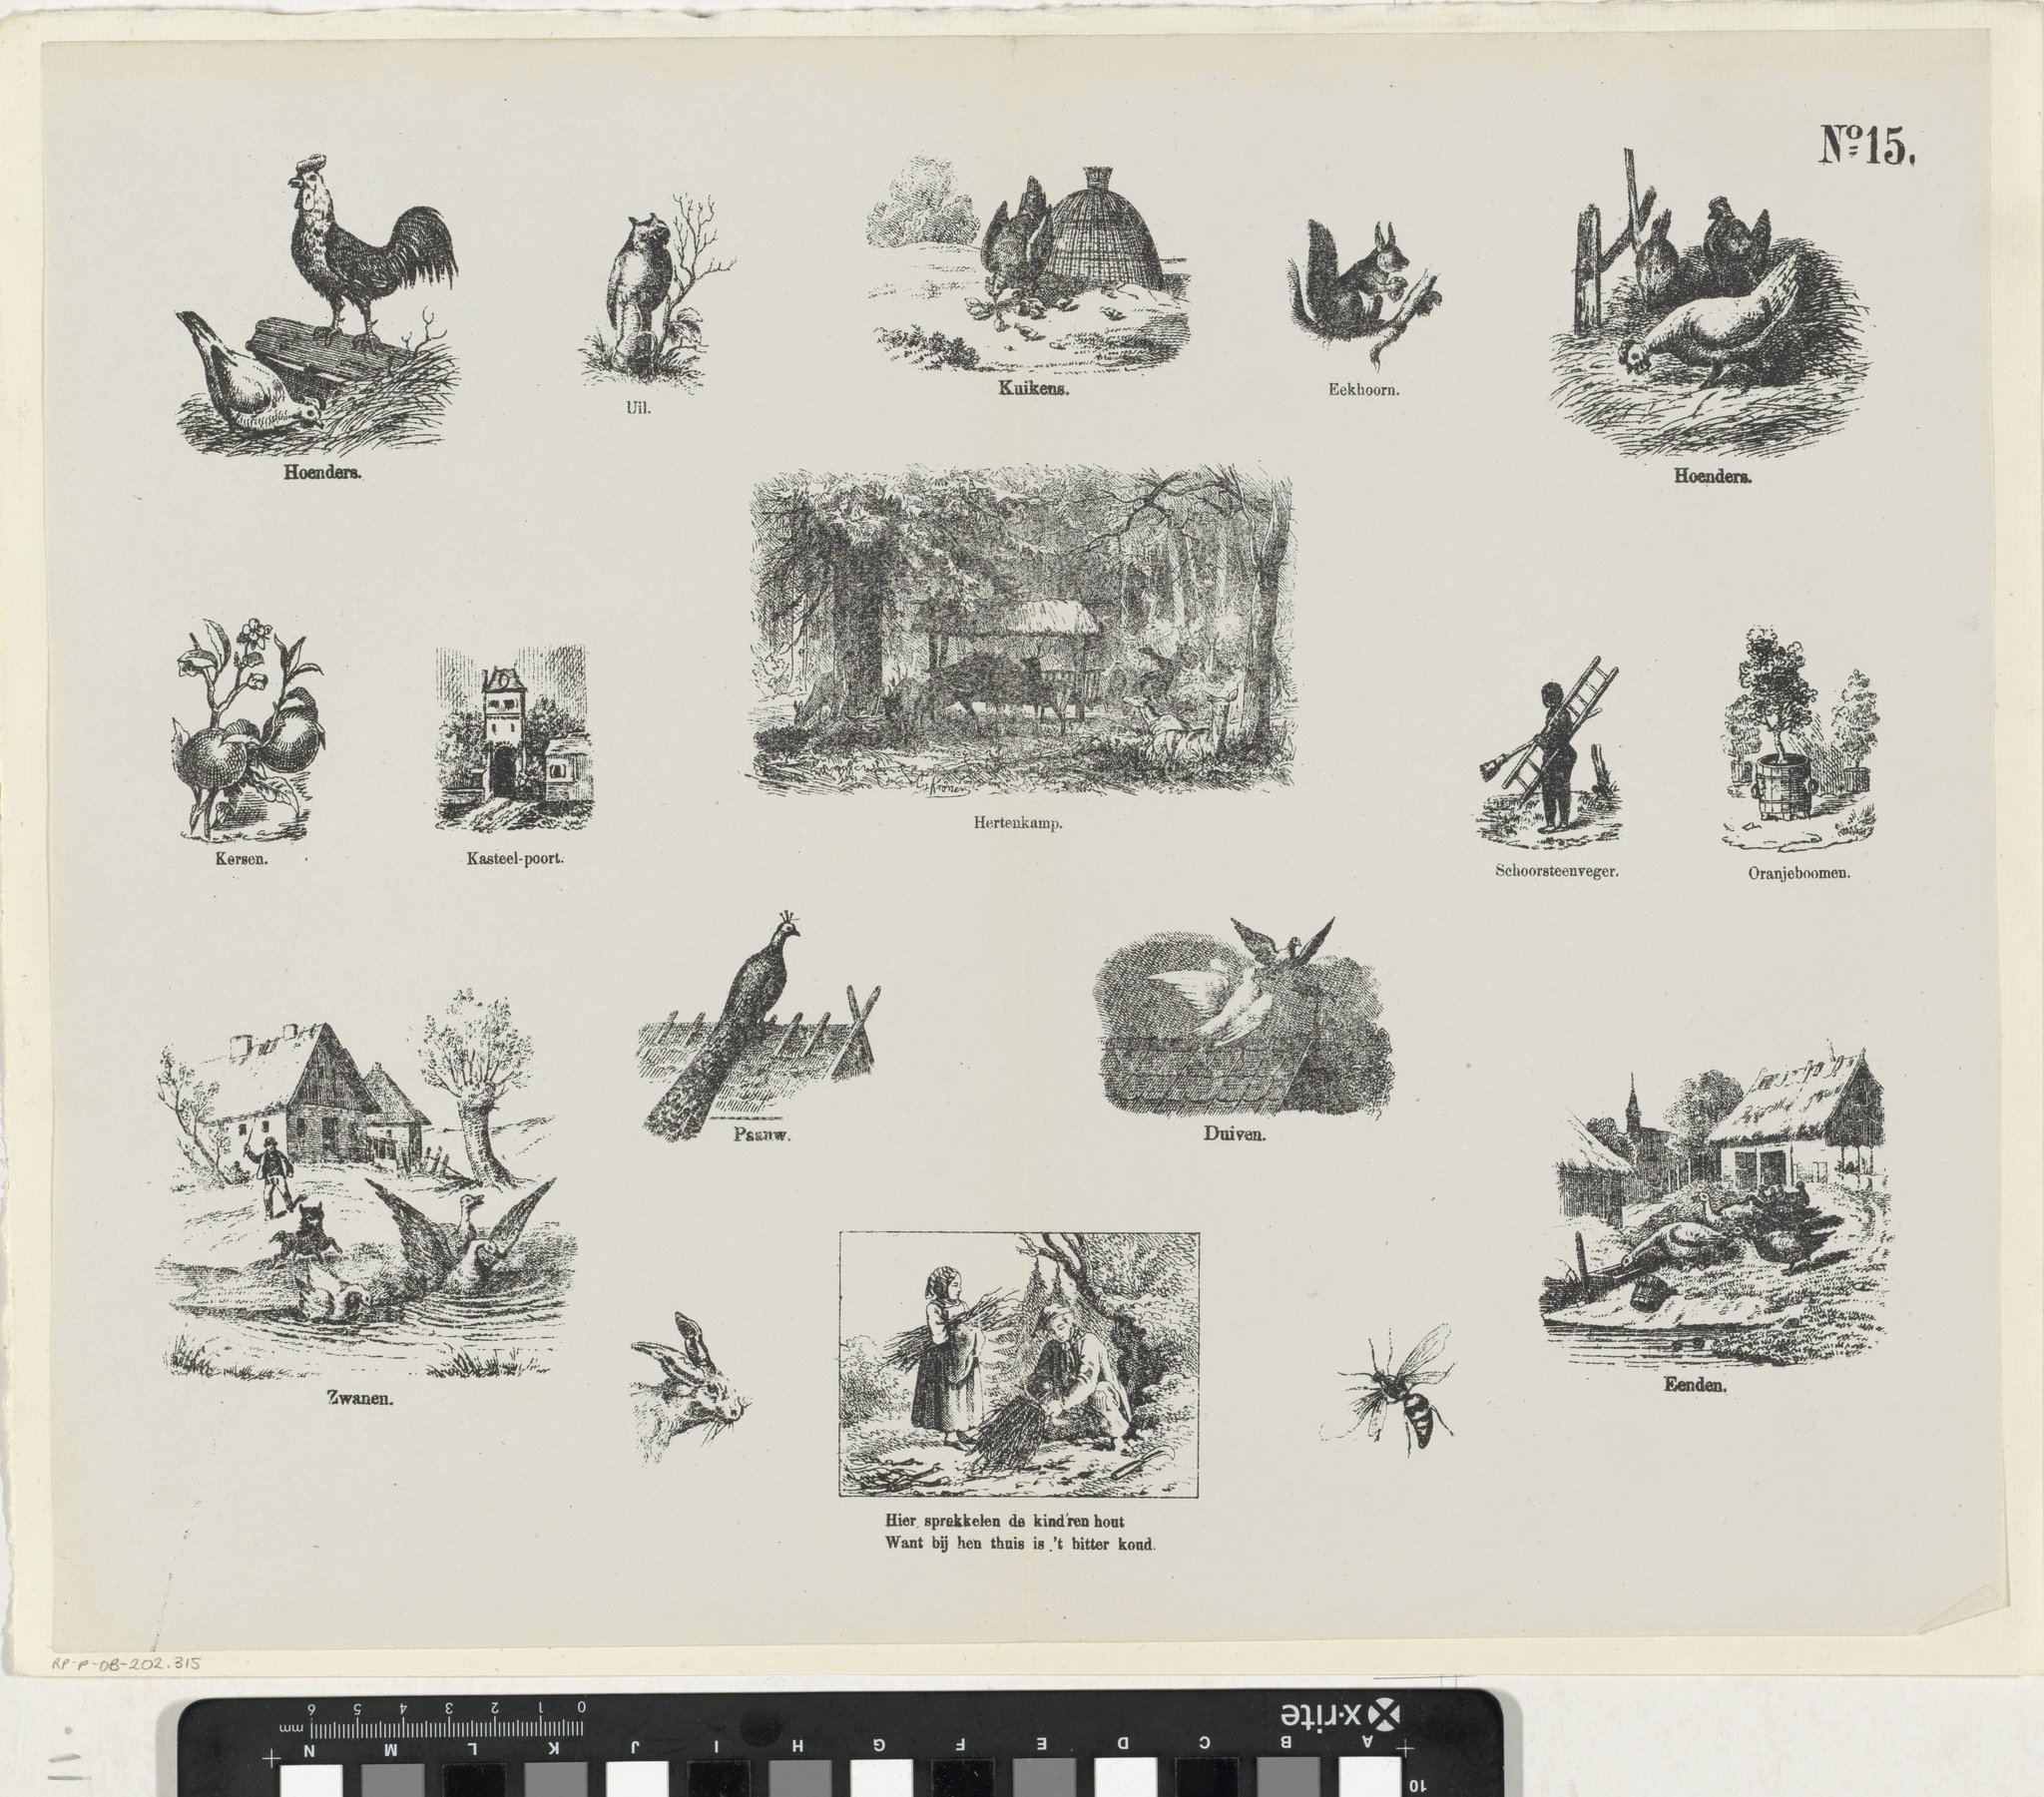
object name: popular print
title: Meijer's prenten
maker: Anonymous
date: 1873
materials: paper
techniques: letterpress printing, lithograph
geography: amsterdam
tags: animals, birds, handicrafts ~ maintenance and repair (with name of trade or profession), fruits: cherry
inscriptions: collector's mark: Lugt 2760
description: Blad met 17 voorstellingen van verschillende aard, waaronder dieren, kinderen die hout sprokkelen en een schoorsteenveger. Onder elke afbeelding een onderschrift. Genummerd rechtsboven: No. 15.